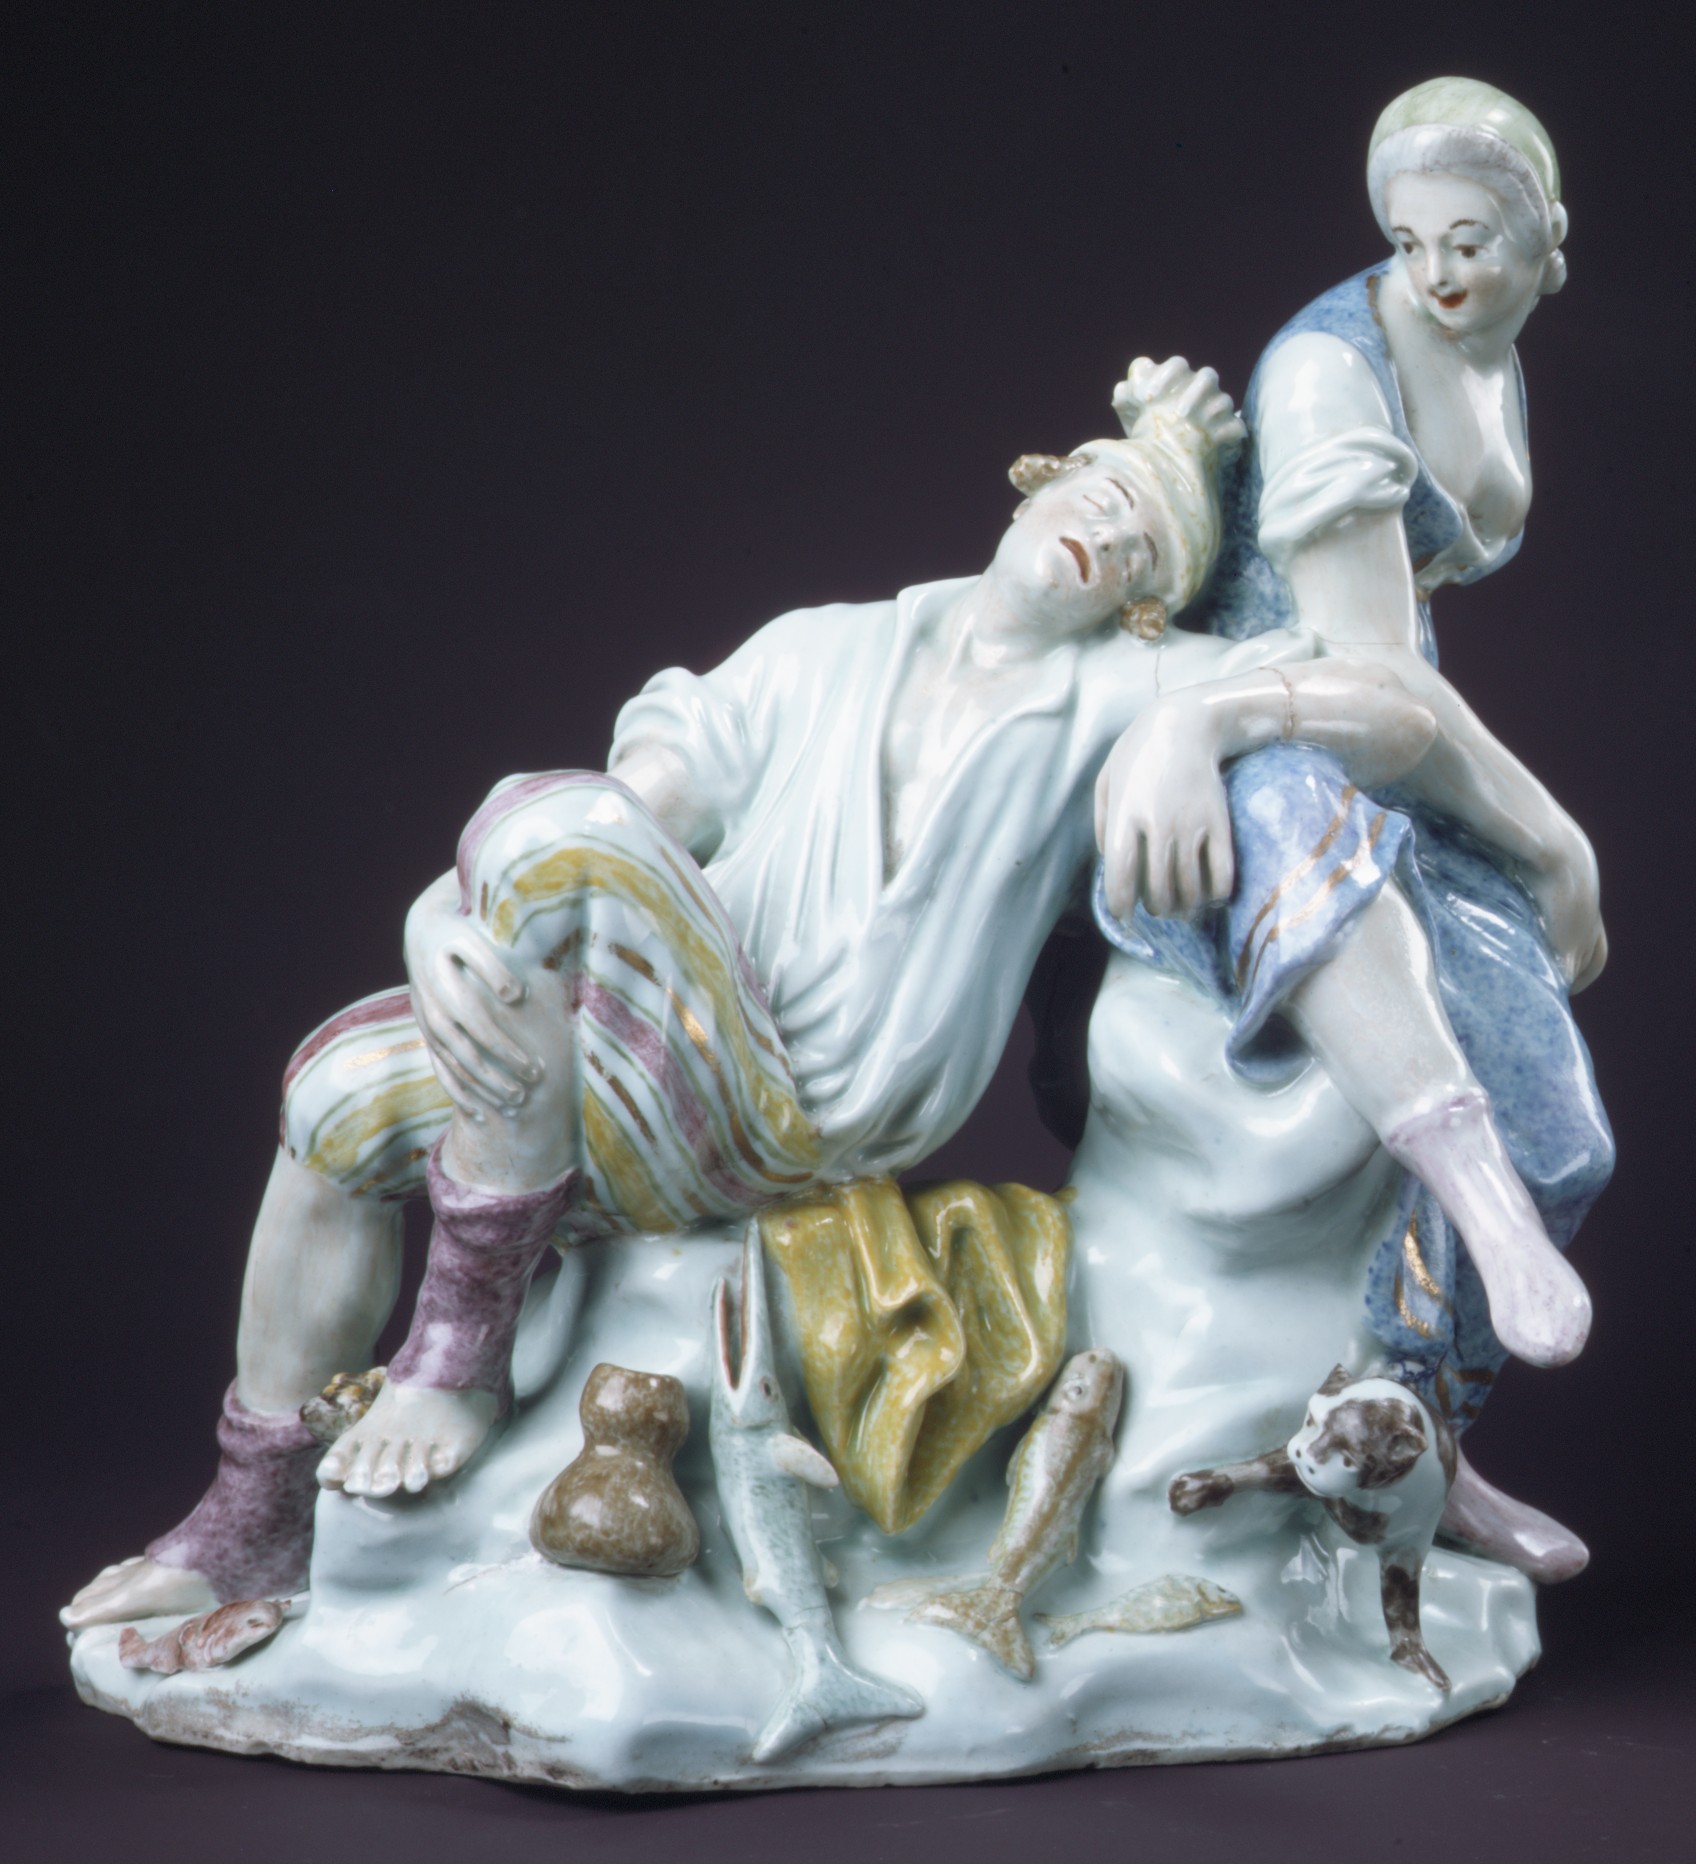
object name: group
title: Fisherman and companion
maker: capodimonte porcelain manufactory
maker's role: manufactory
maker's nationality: italian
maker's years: 1740-1759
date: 1755-1759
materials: soft paste porcelain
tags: men,women,cats,fish